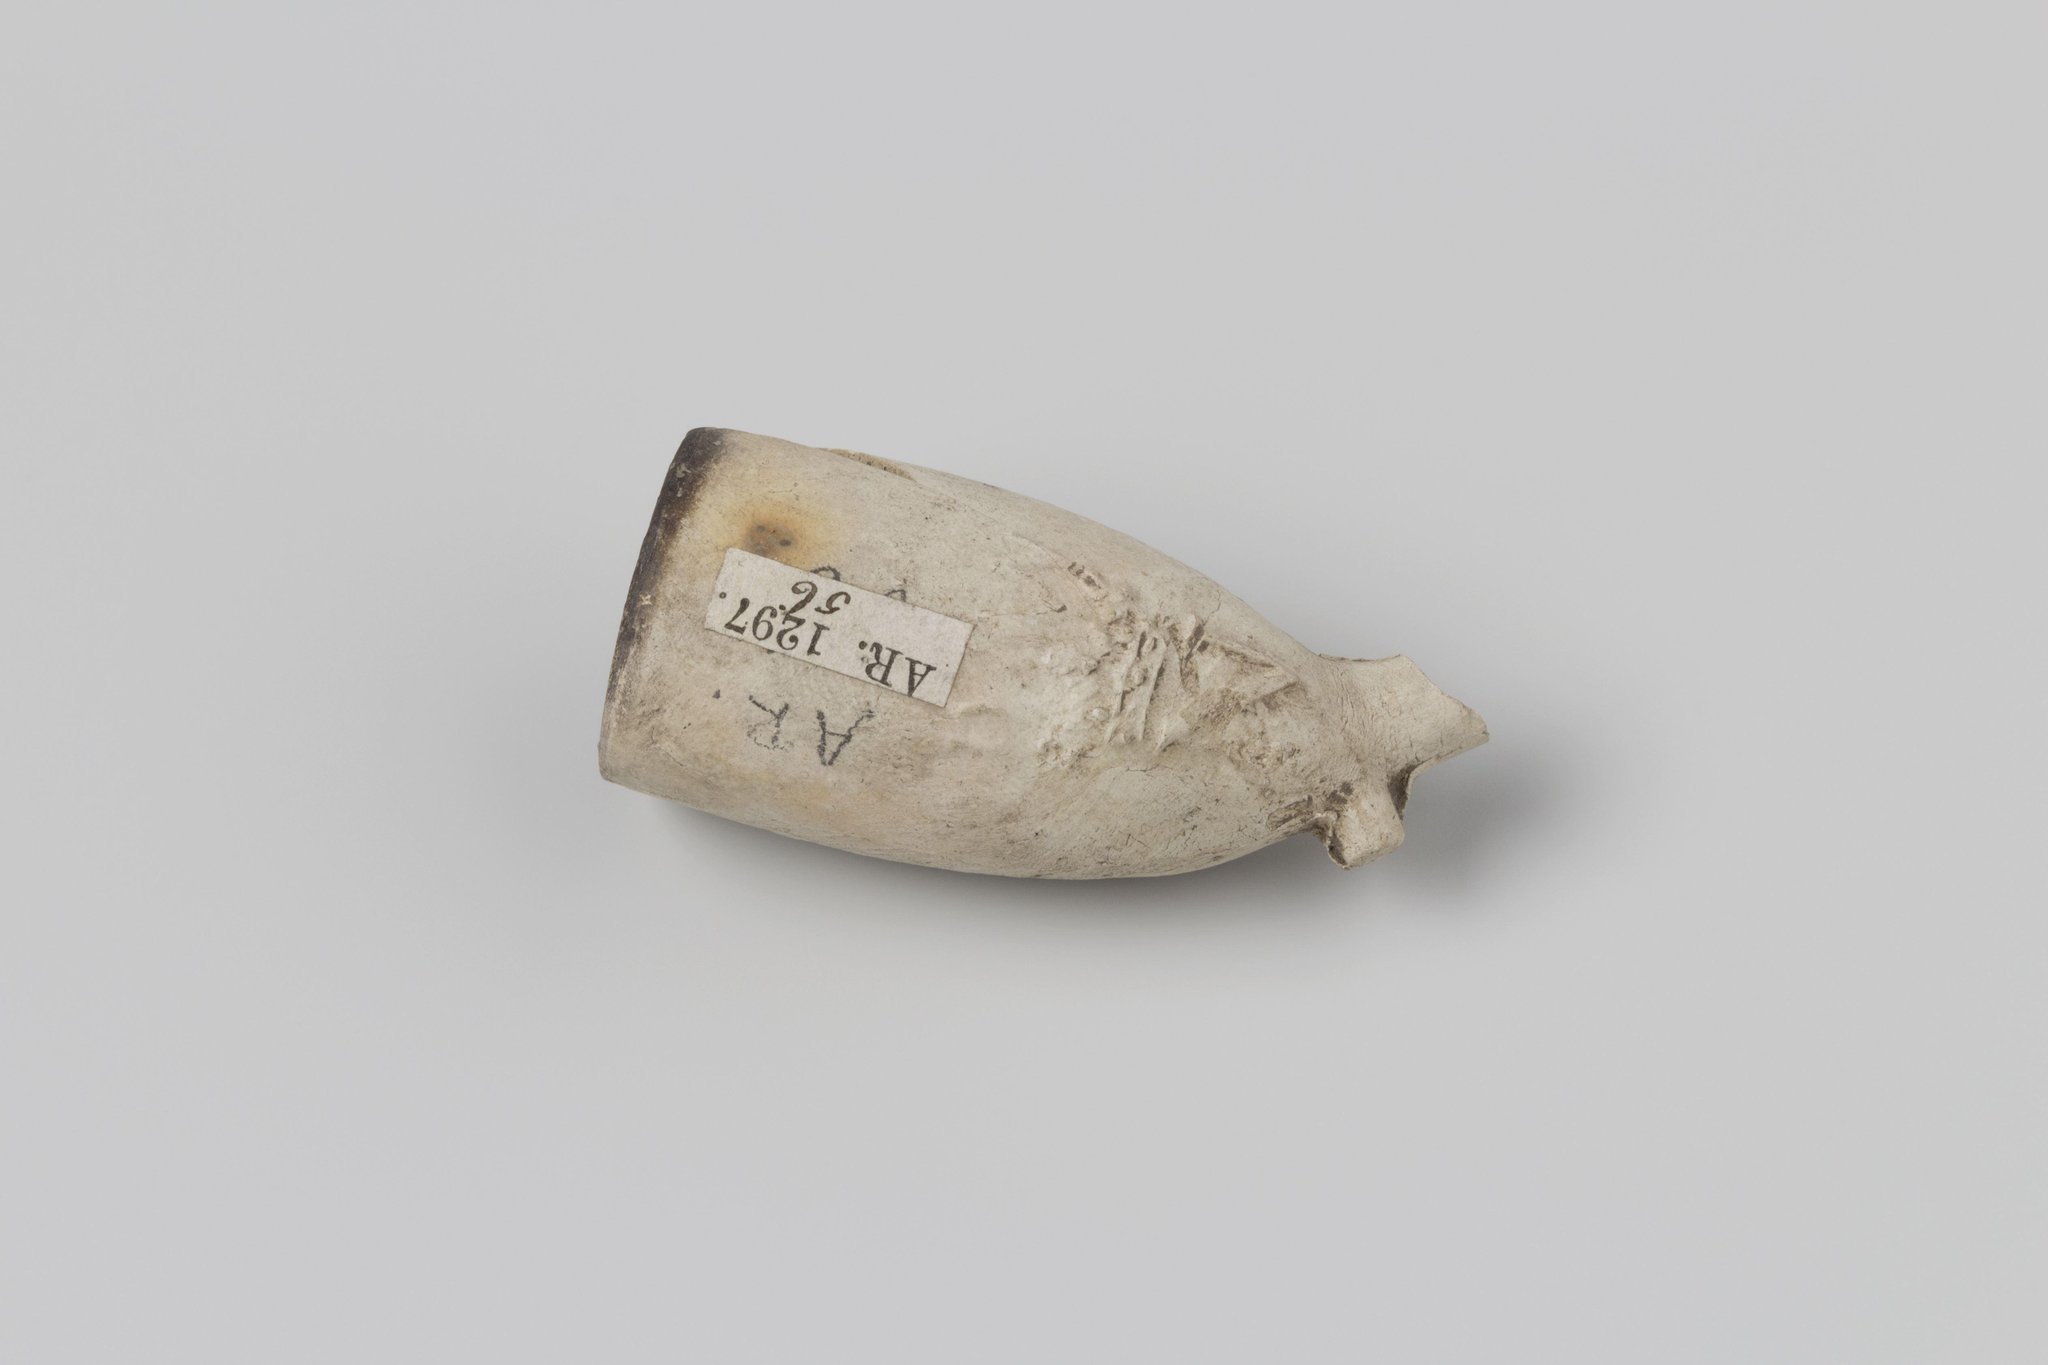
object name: fragment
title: Pijpenkop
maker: dirk barunet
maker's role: pijpenfabrikant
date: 1750-1785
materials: clay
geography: gorinchem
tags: directeur, hoogleraar, caspar jacob christiaan reuvens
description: Pijpenkop met een kroon afgebeeld. Van de opgravingen op de Hofstede Arentsburg 1827-1831 onder toezicht van Professor Reuvens.